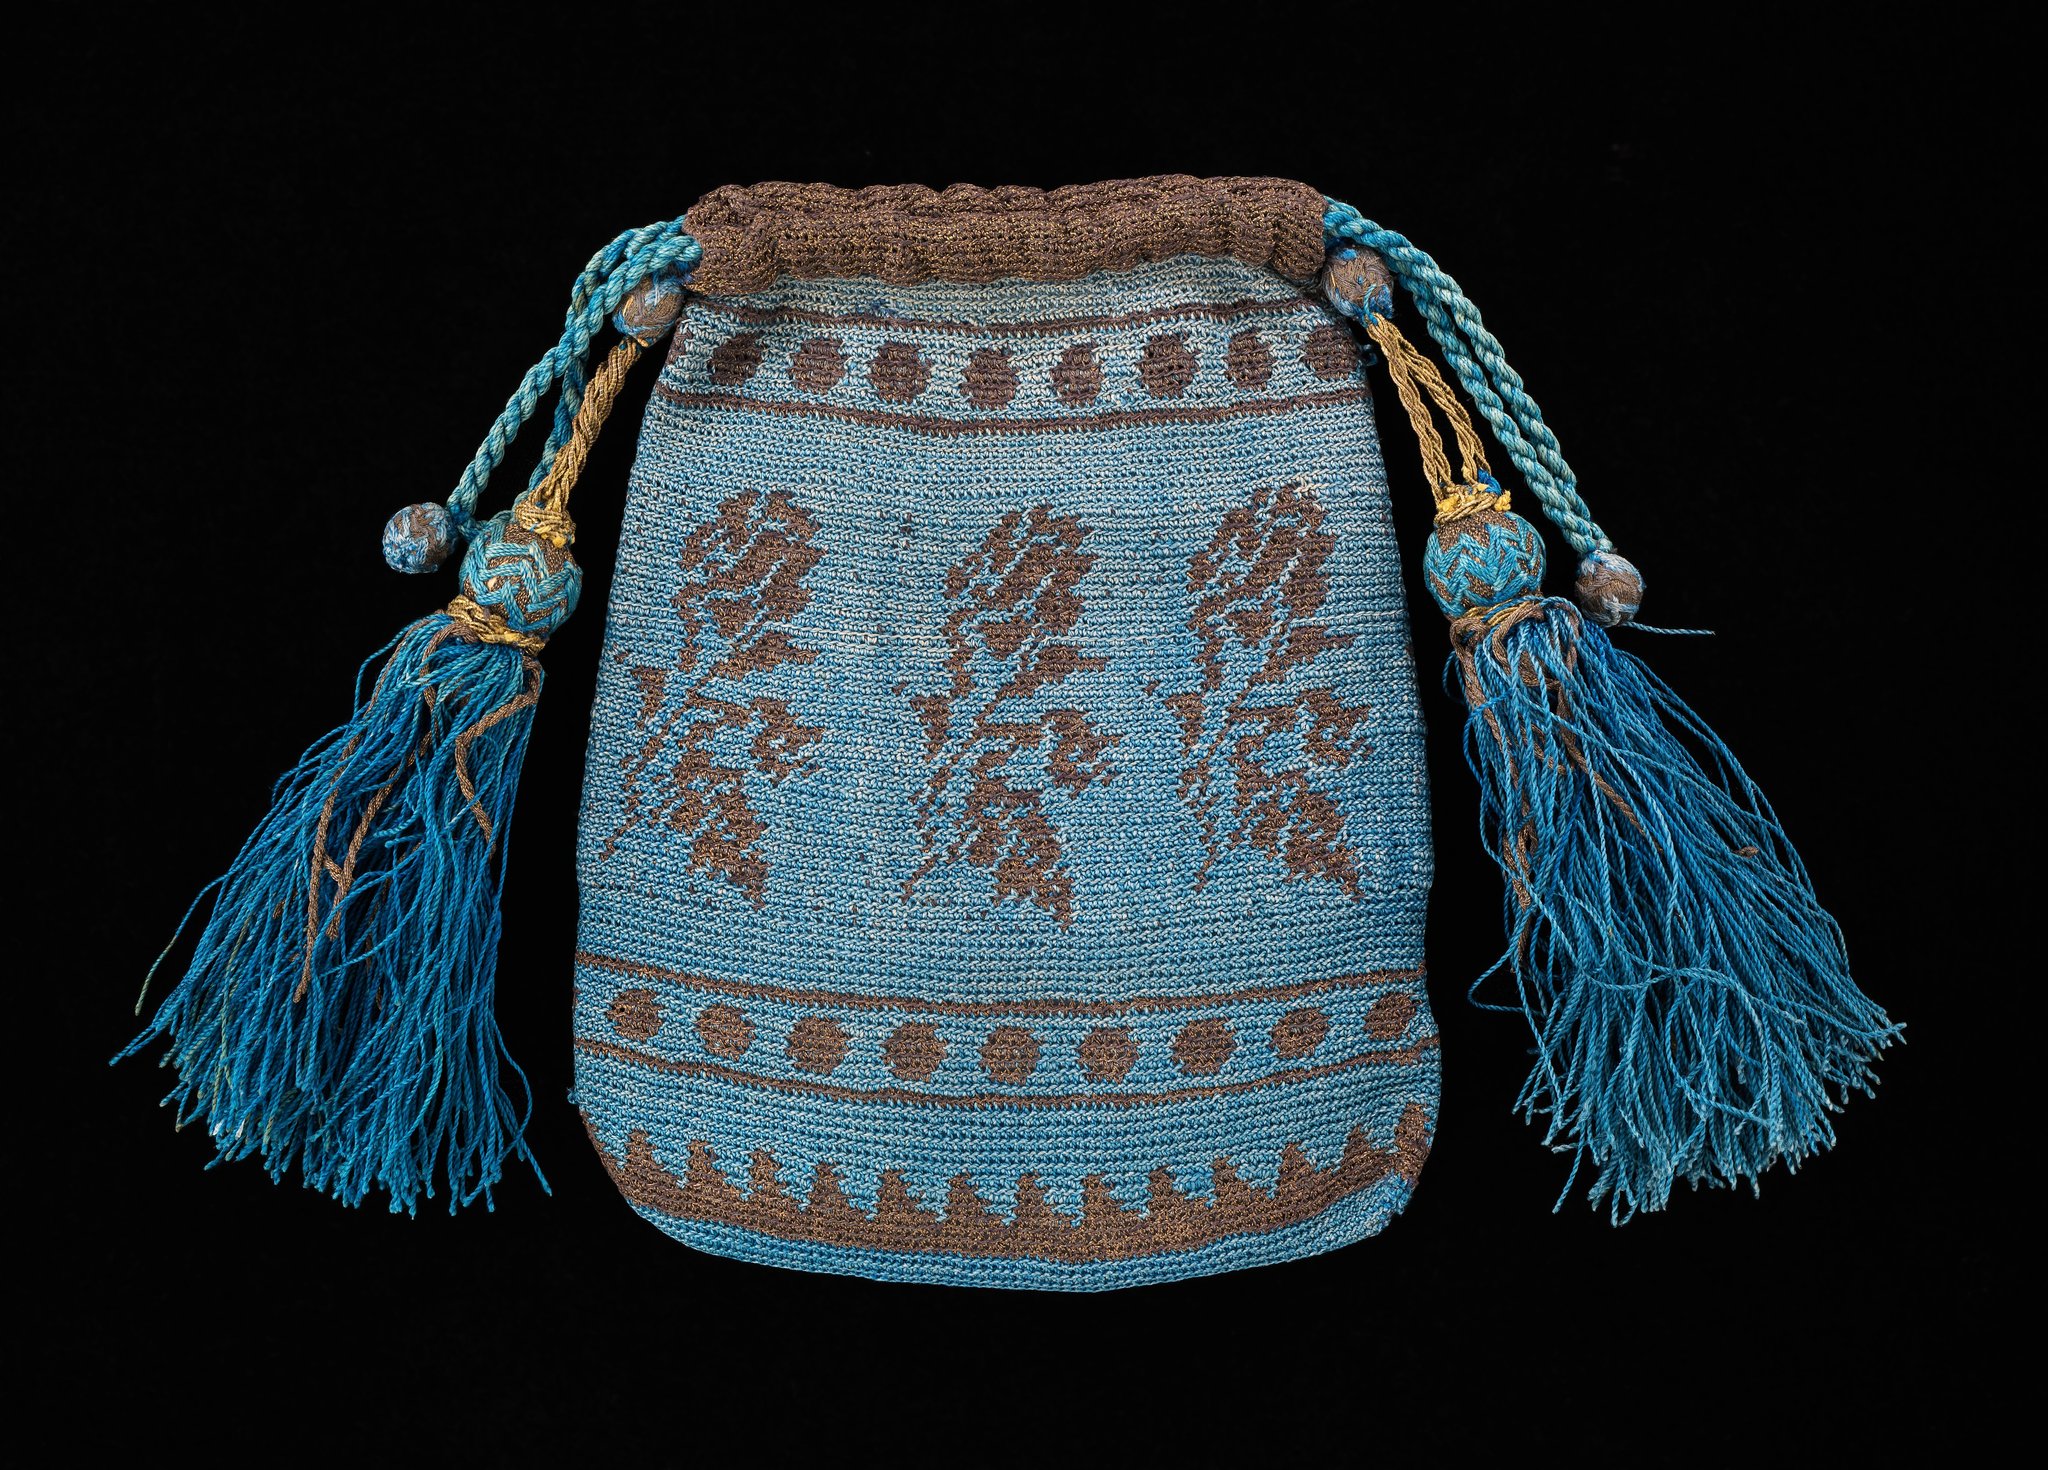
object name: evening pouch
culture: american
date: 1826-1850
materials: metal, silk